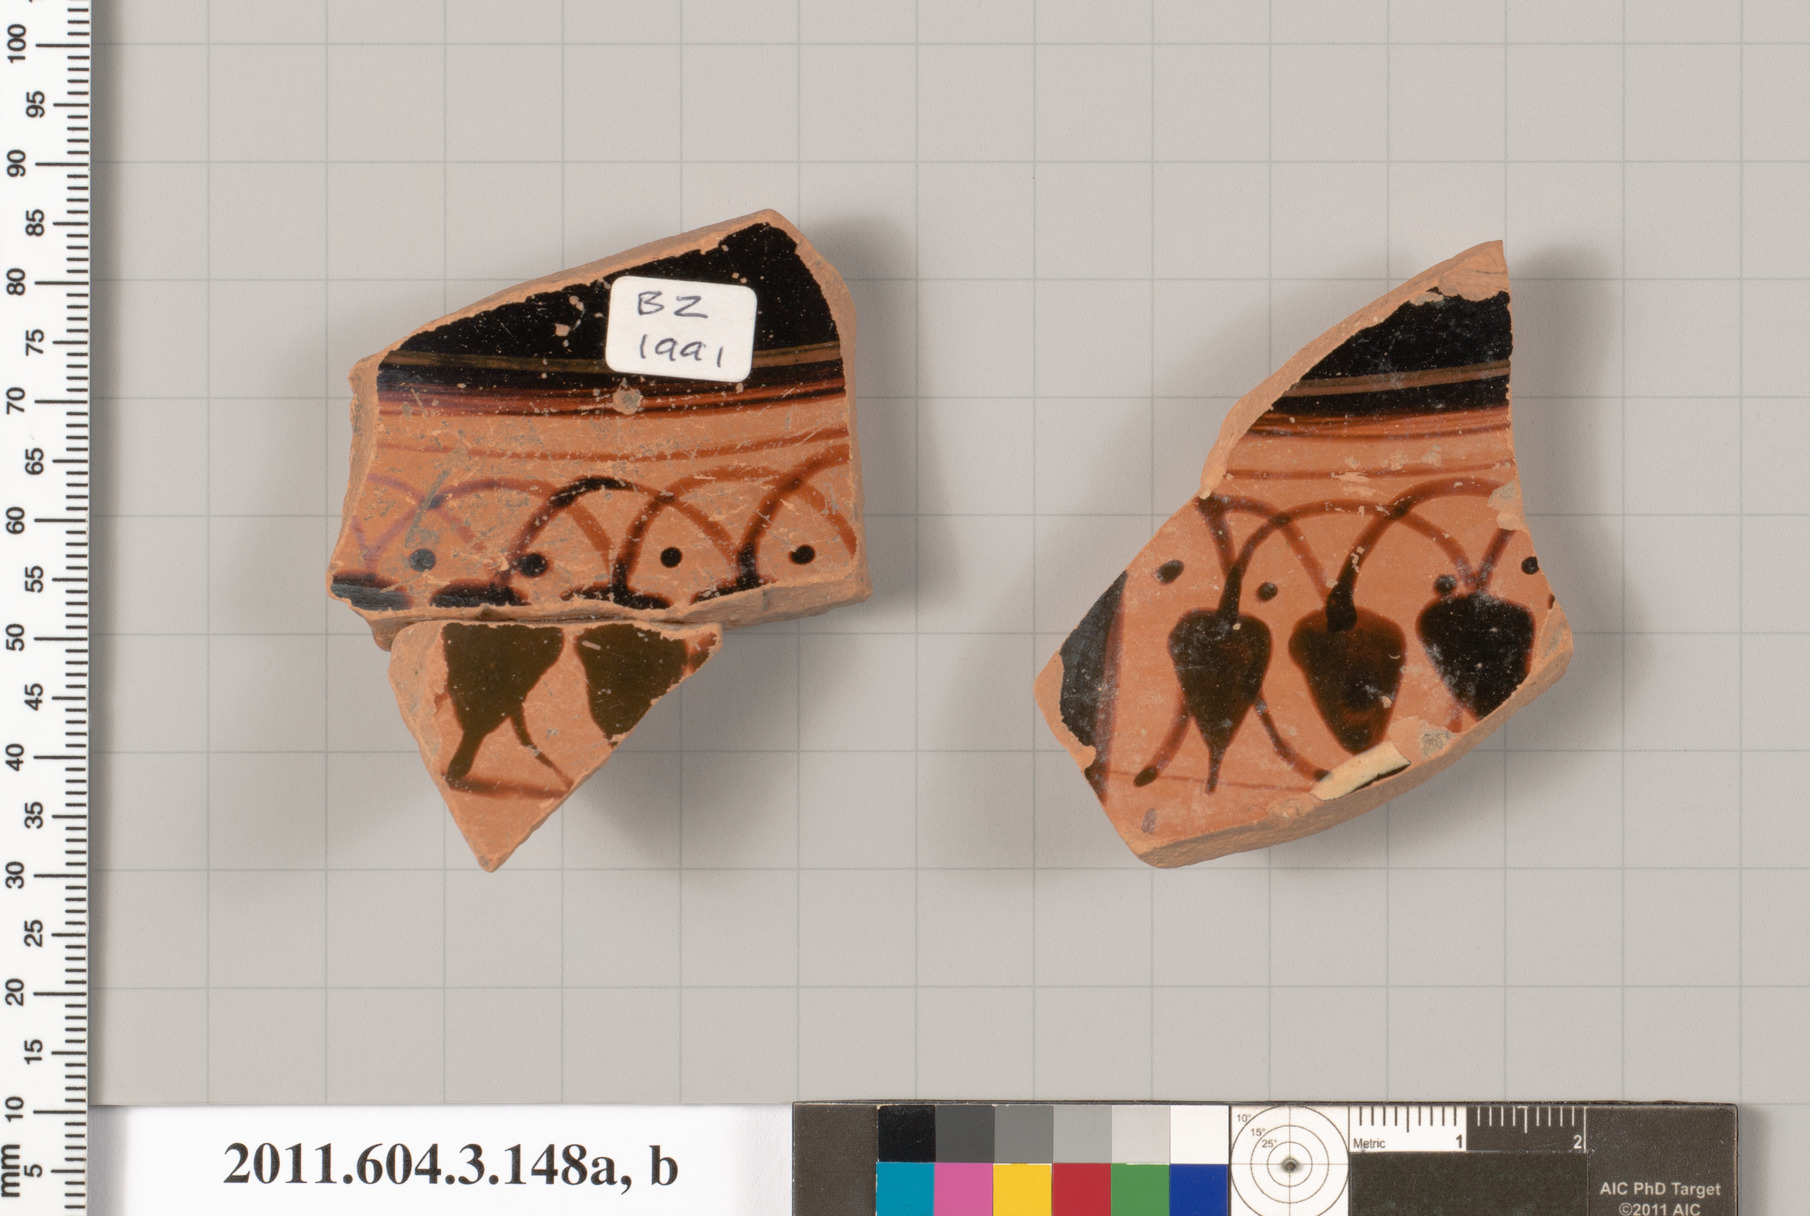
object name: amphora fragment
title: Terracotta fragments of an amphora (jar)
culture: greek, attic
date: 540-530 BCE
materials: terracotta